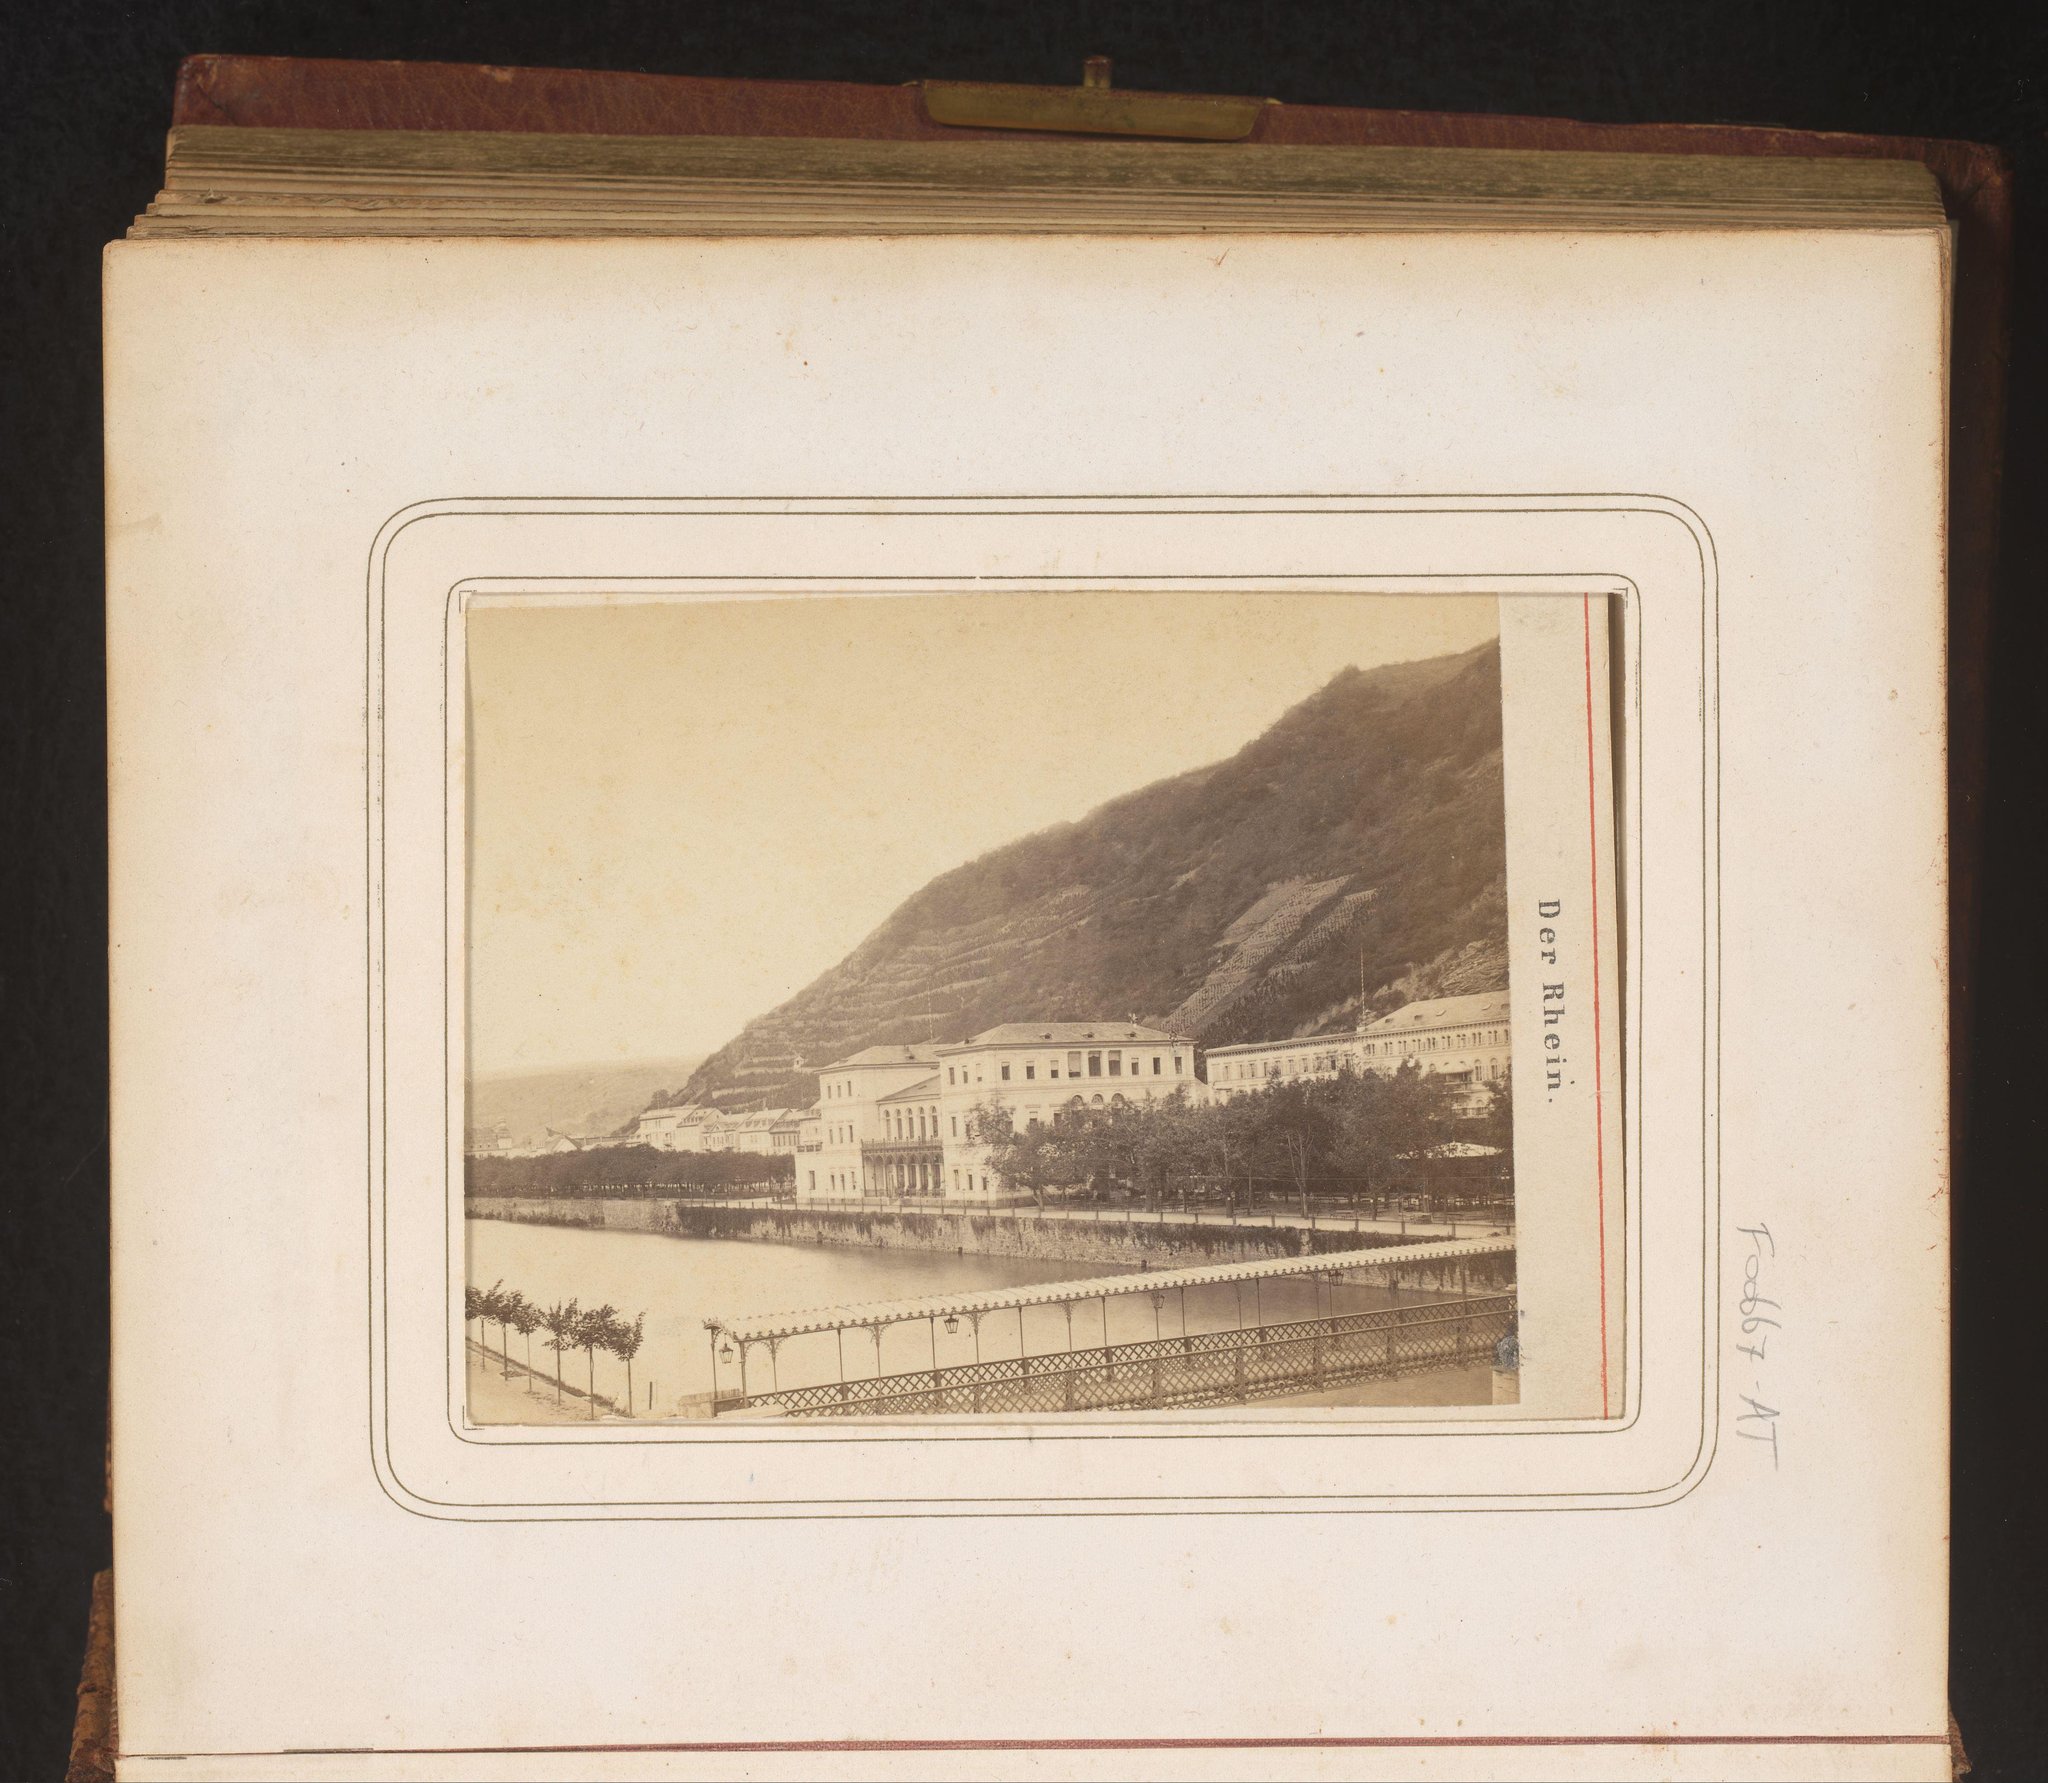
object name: cabinet photograph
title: Gezicht op een rivier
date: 1870-1890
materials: cardboard, photographic support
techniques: albumen print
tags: landscapes with waters, waterscapes, seascapes (in the temperate zone), mountains, germany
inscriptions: inscription: ‘5. Ems, der Kursaal’